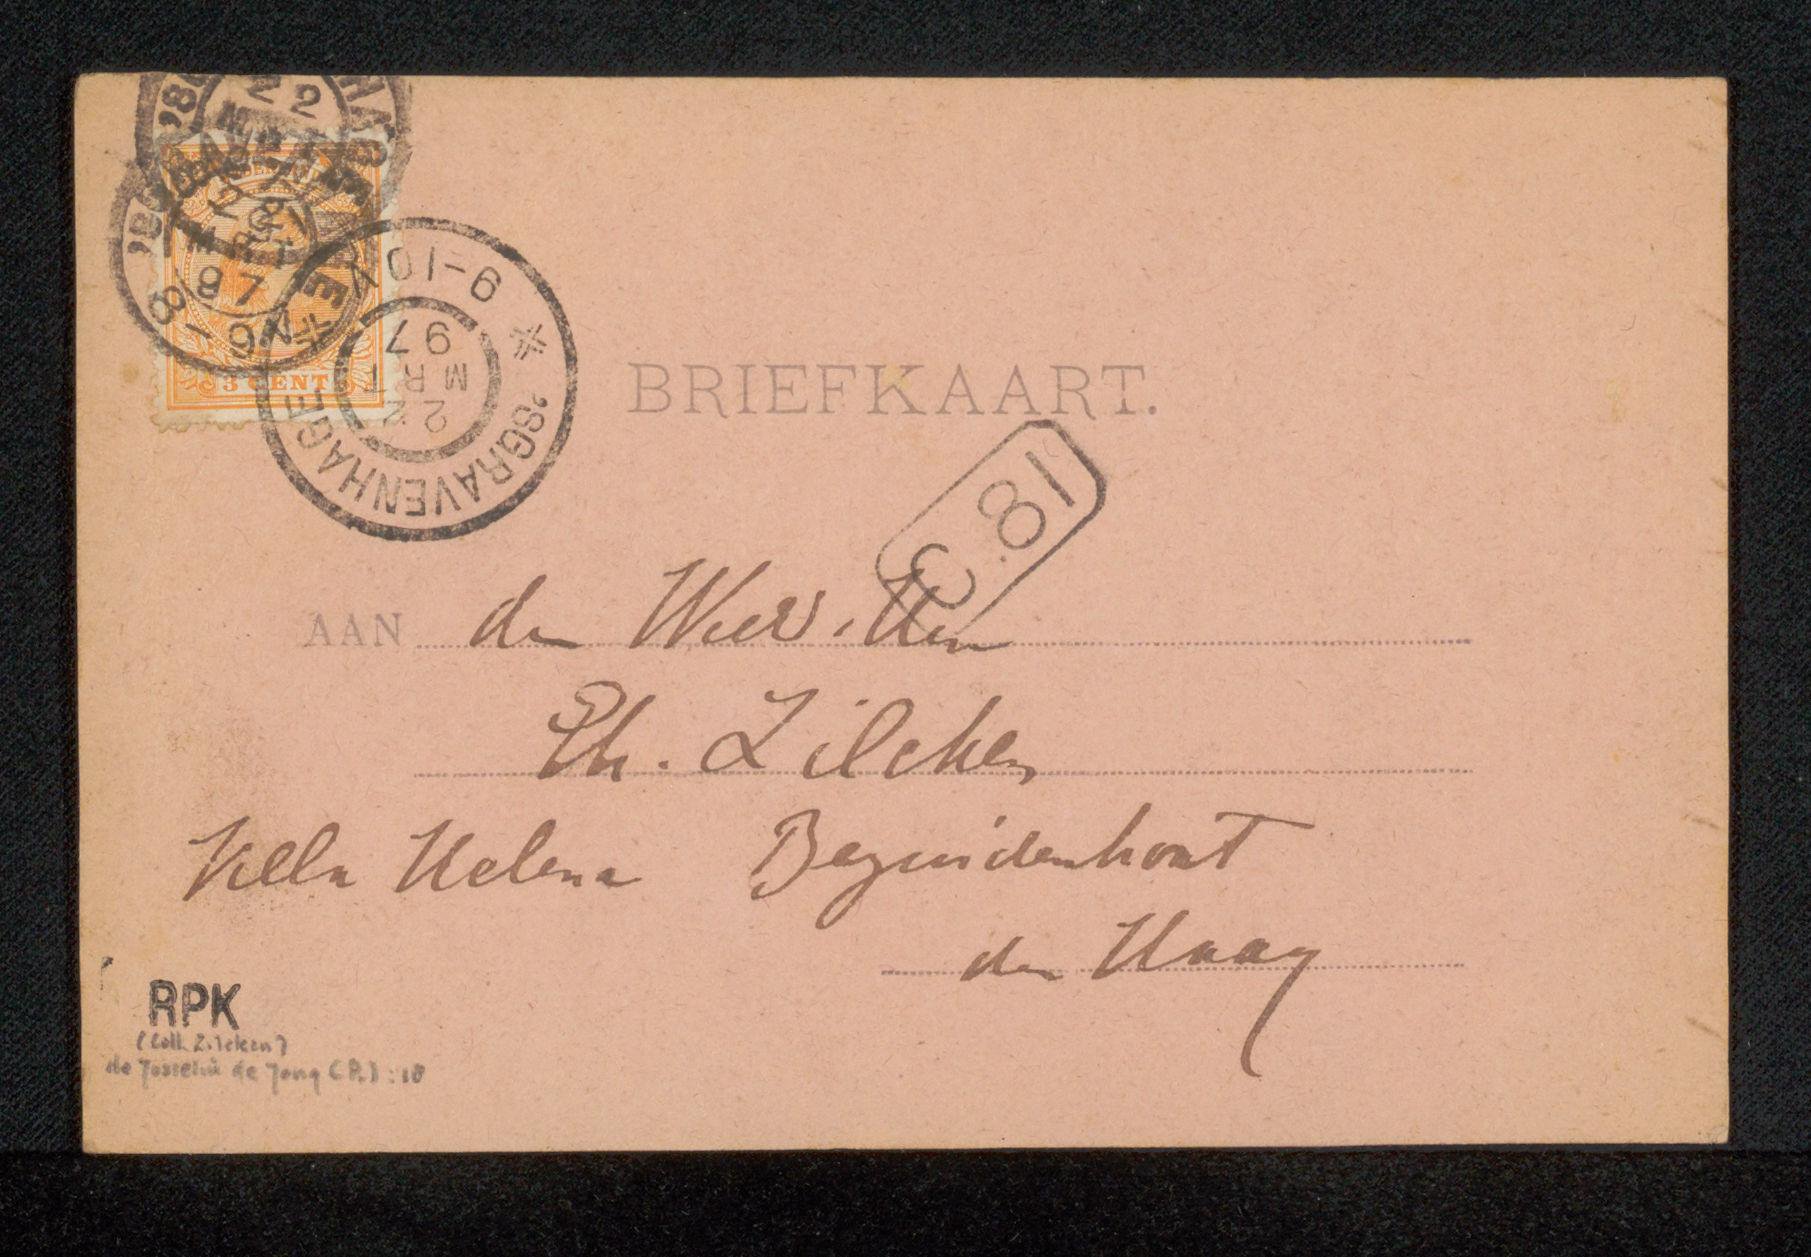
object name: postcard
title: Briefkaart aan Philip Zilcken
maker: pieter de josselin de jong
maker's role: draughtsman, painter, print maker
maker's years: 1861-1906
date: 1897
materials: cardboard, ink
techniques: writing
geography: the hague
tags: print maker, draughtsman, thérèse schwartze, the hague, philip zilcken, literature ~ arts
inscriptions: collector's mark: ‘RPK’